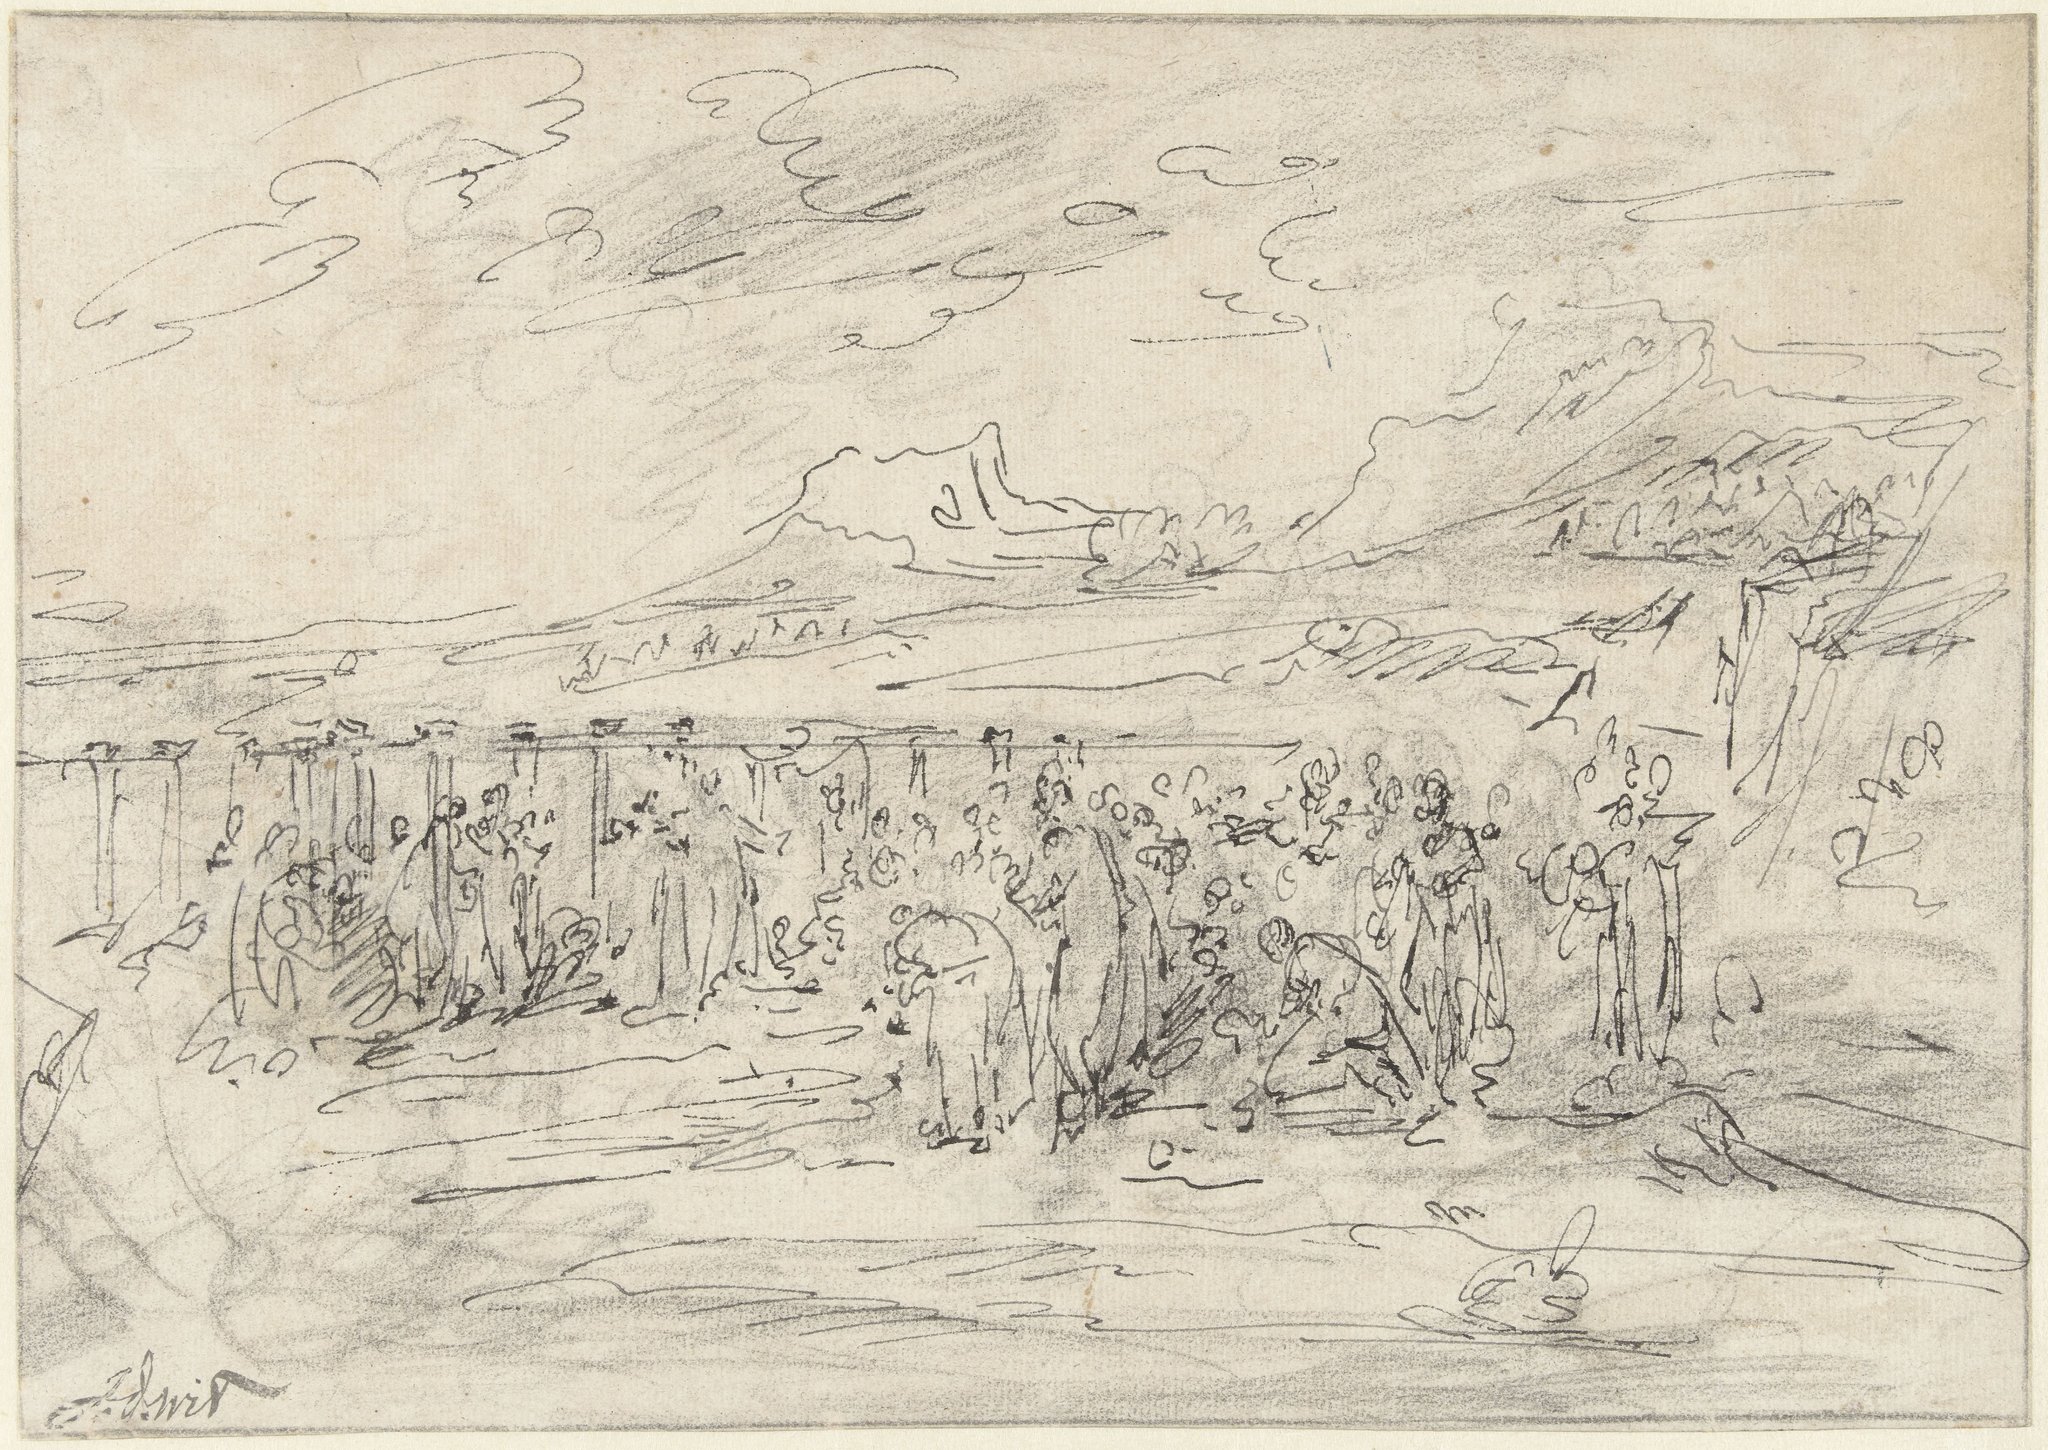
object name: drawing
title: Mozes verkiest de zeventig oudsten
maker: jacob de wit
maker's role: draughtsman, painter, print maker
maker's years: 1695-1754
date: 1736-1737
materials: chalk, ink, paper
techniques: pen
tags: moses chooses seventy elders to assist him and places them round the tabernacle; the spirit of god descends upon them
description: Ontwerp voor schildering in Vroedschapszaal, Stadhuis Amsterdam.